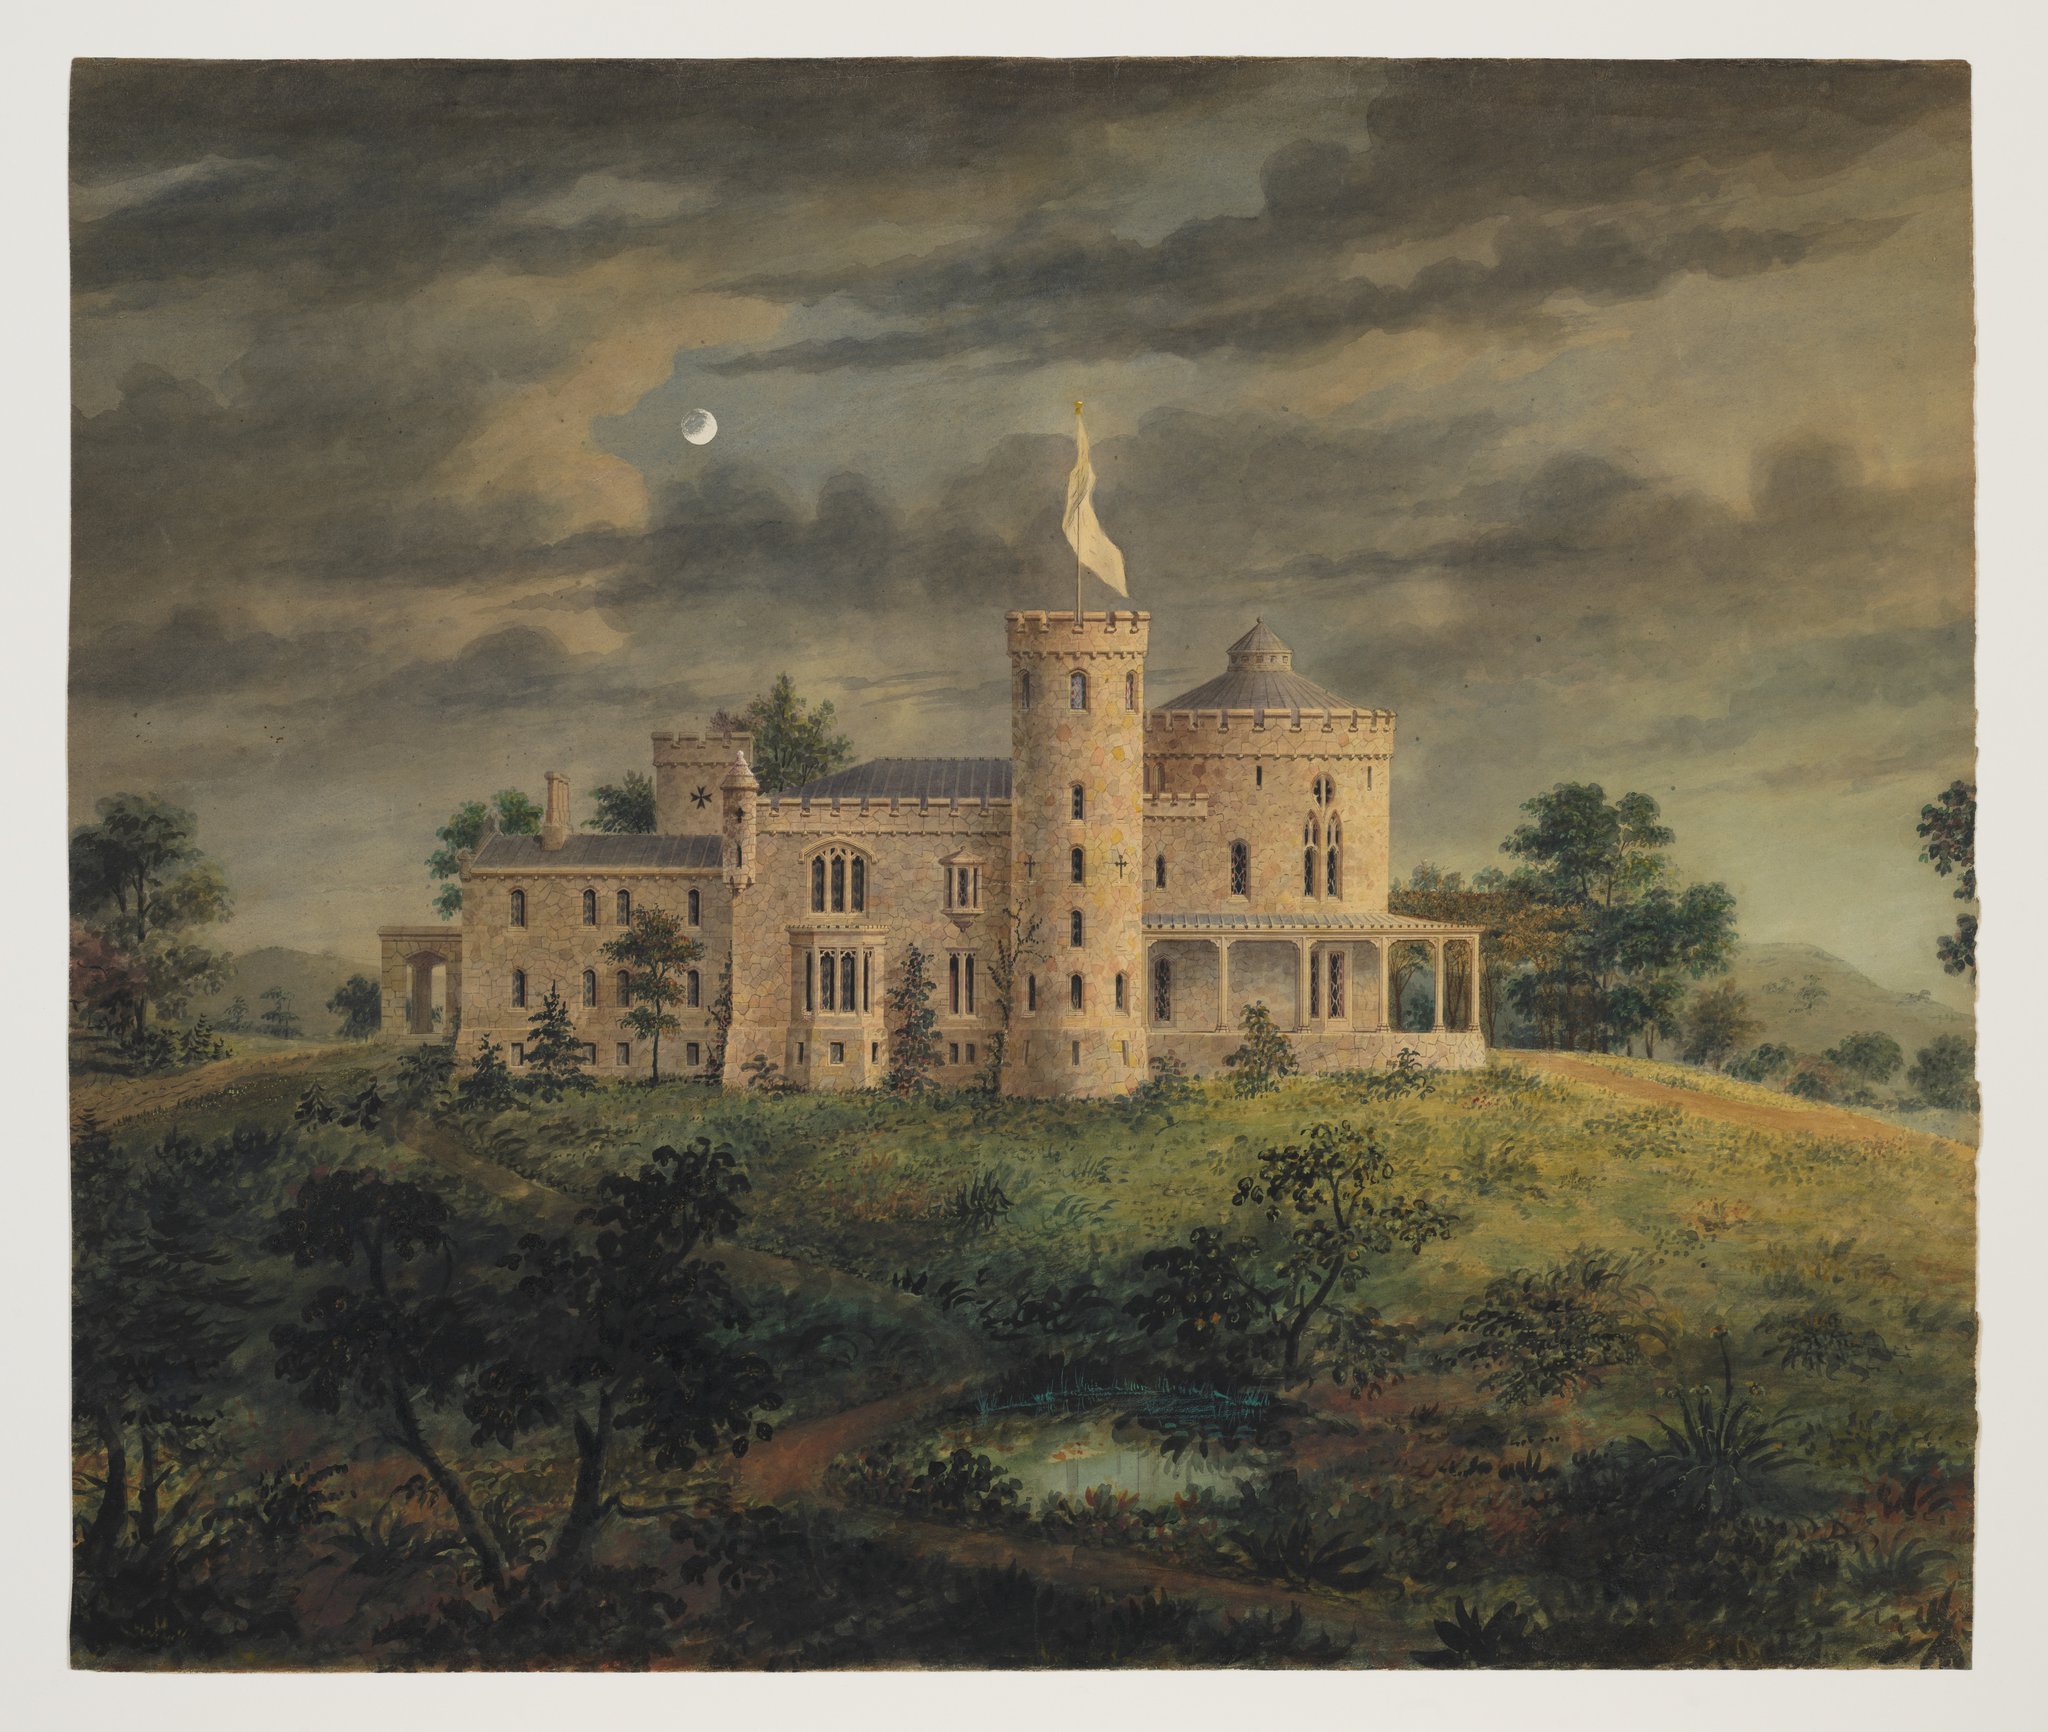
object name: drawing ornament architecture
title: Ericstan, for John J. Herrick, Tarrytown, New York (perspective)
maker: alexander jackson davis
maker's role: artist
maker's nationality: american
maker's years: 1803-1892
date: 1855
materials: graphite, ink, paper, watercolor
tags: architecture,houses,towers